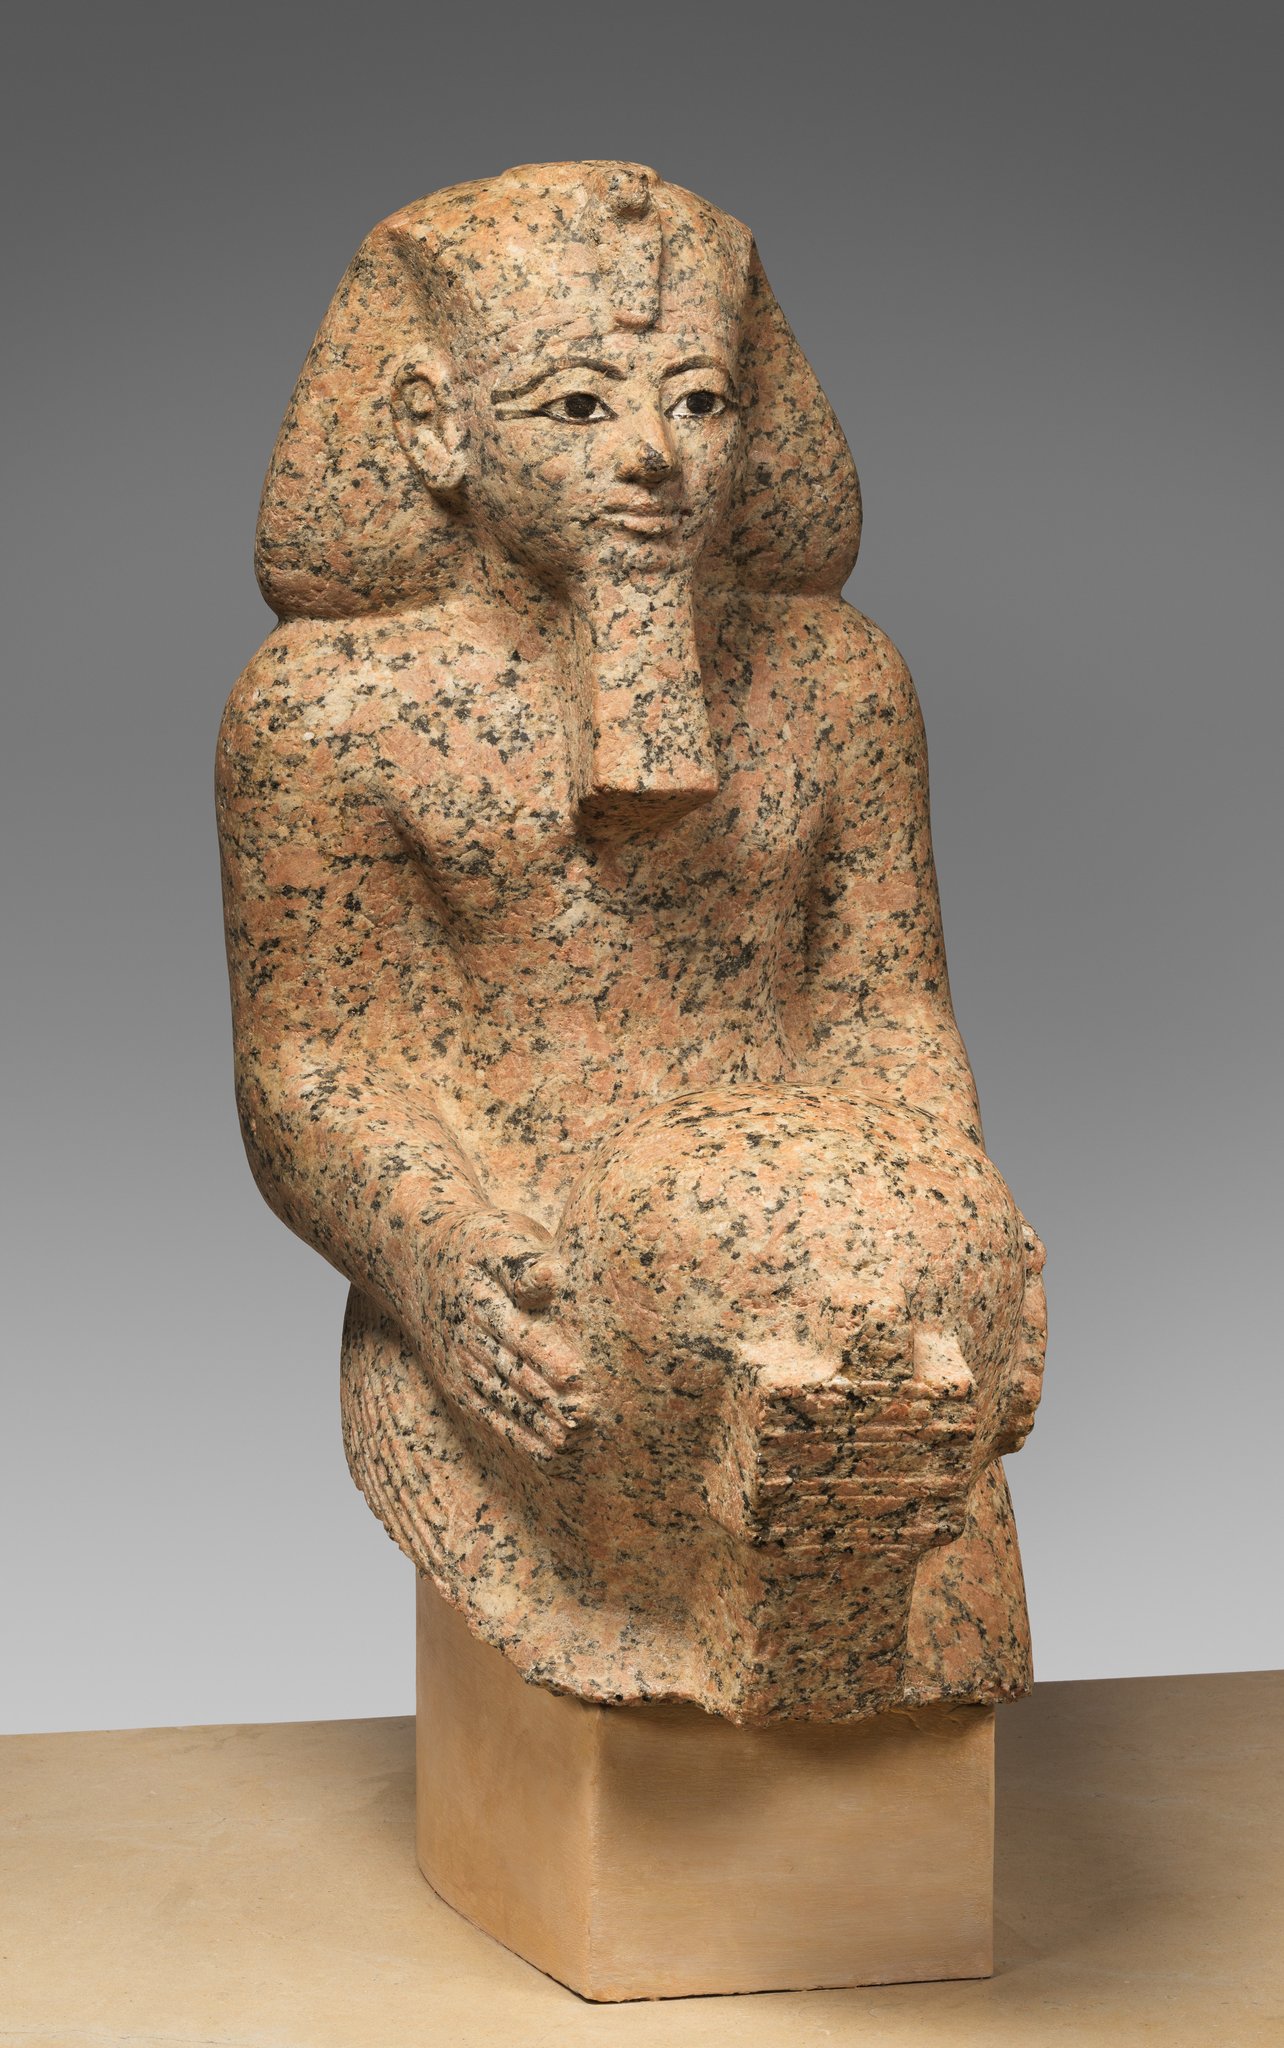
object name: statue, hatshepsut kneeling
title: Kneeling statue of Hatshepsut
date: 1479-1458 BCE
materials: granite, paint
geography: egypt